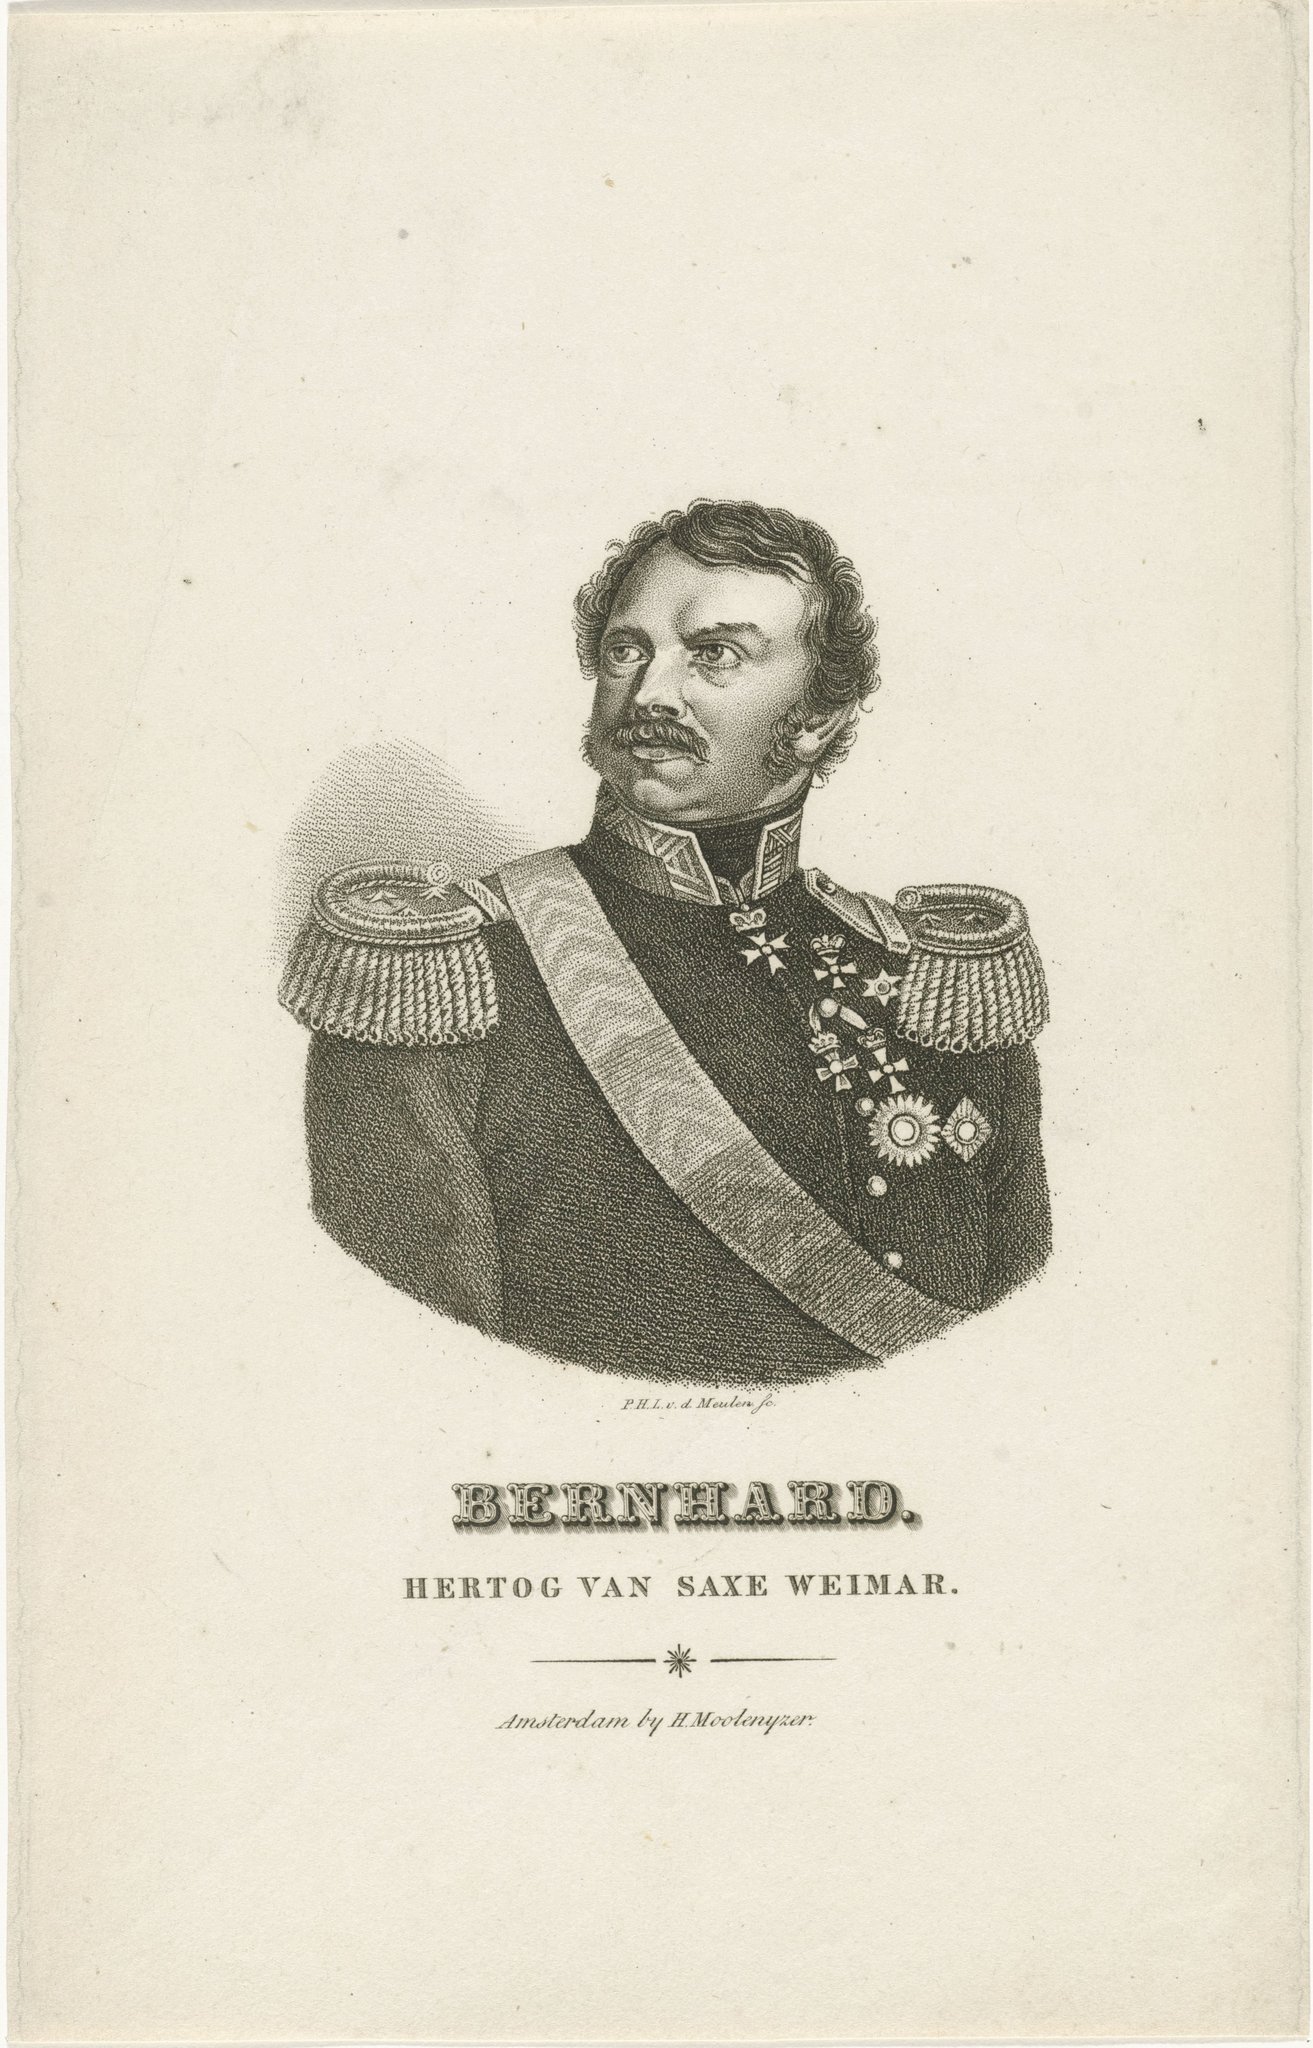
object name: print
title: Portret van hertog Bernhard Karel van Saxen-Weimar-Eisenach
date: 1790-1858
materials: paper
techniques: engraving, roulette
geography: amsterdam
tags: karel bernhard (hertog van saksen-weimar-eisenach)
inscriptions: collector's mark: Lugt 2228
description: Portret van hertog Bernhard Karel van Saxen-Weimar-Eisenach met onderscheidingen op zijn borst, waaronder de Militaire Willems-Orde. Hij vocht onder andere aan Nederlandse zijde in de Slag bij Waterloo.